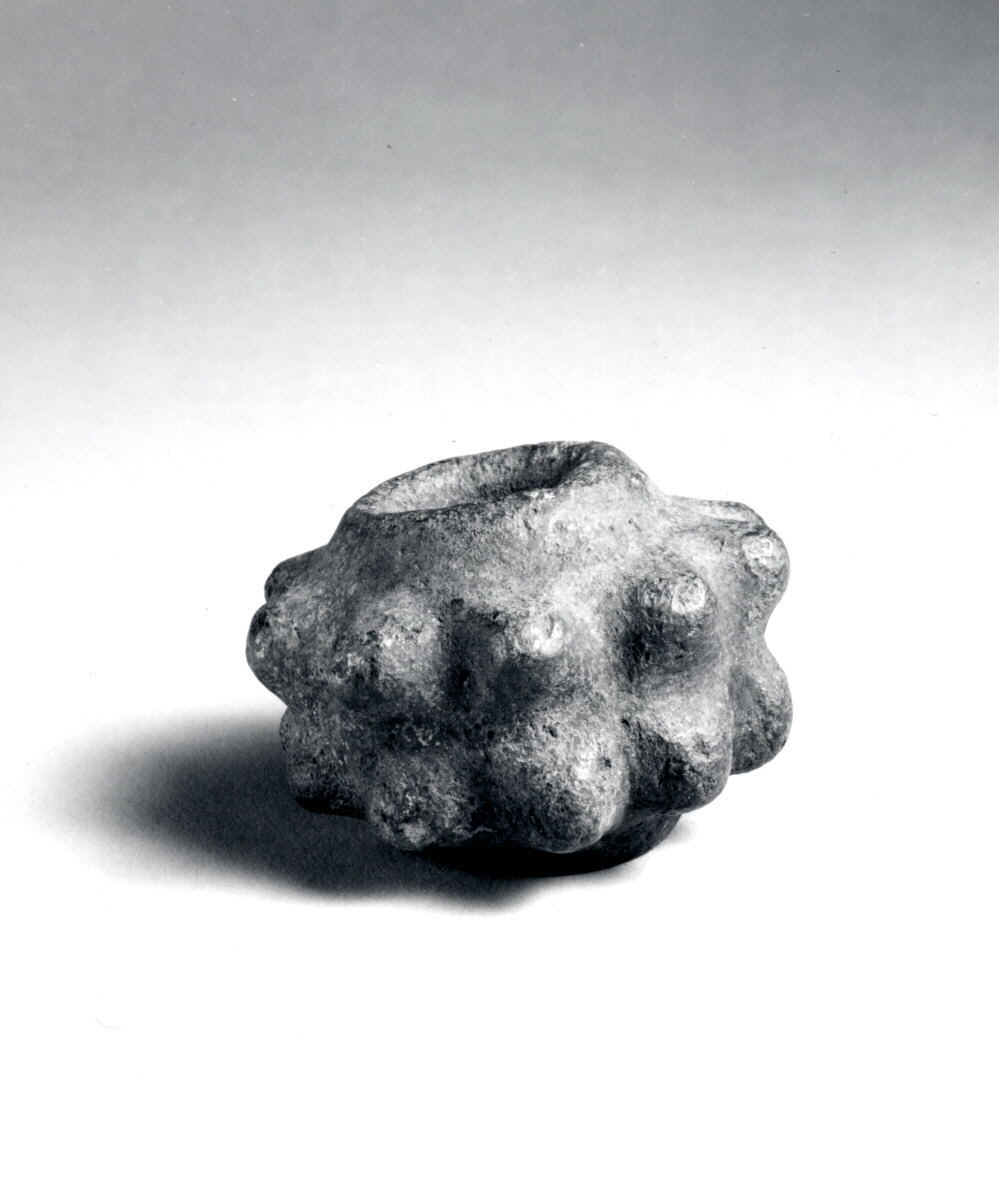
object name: club head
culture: highlands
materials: stone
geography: papua new guinea